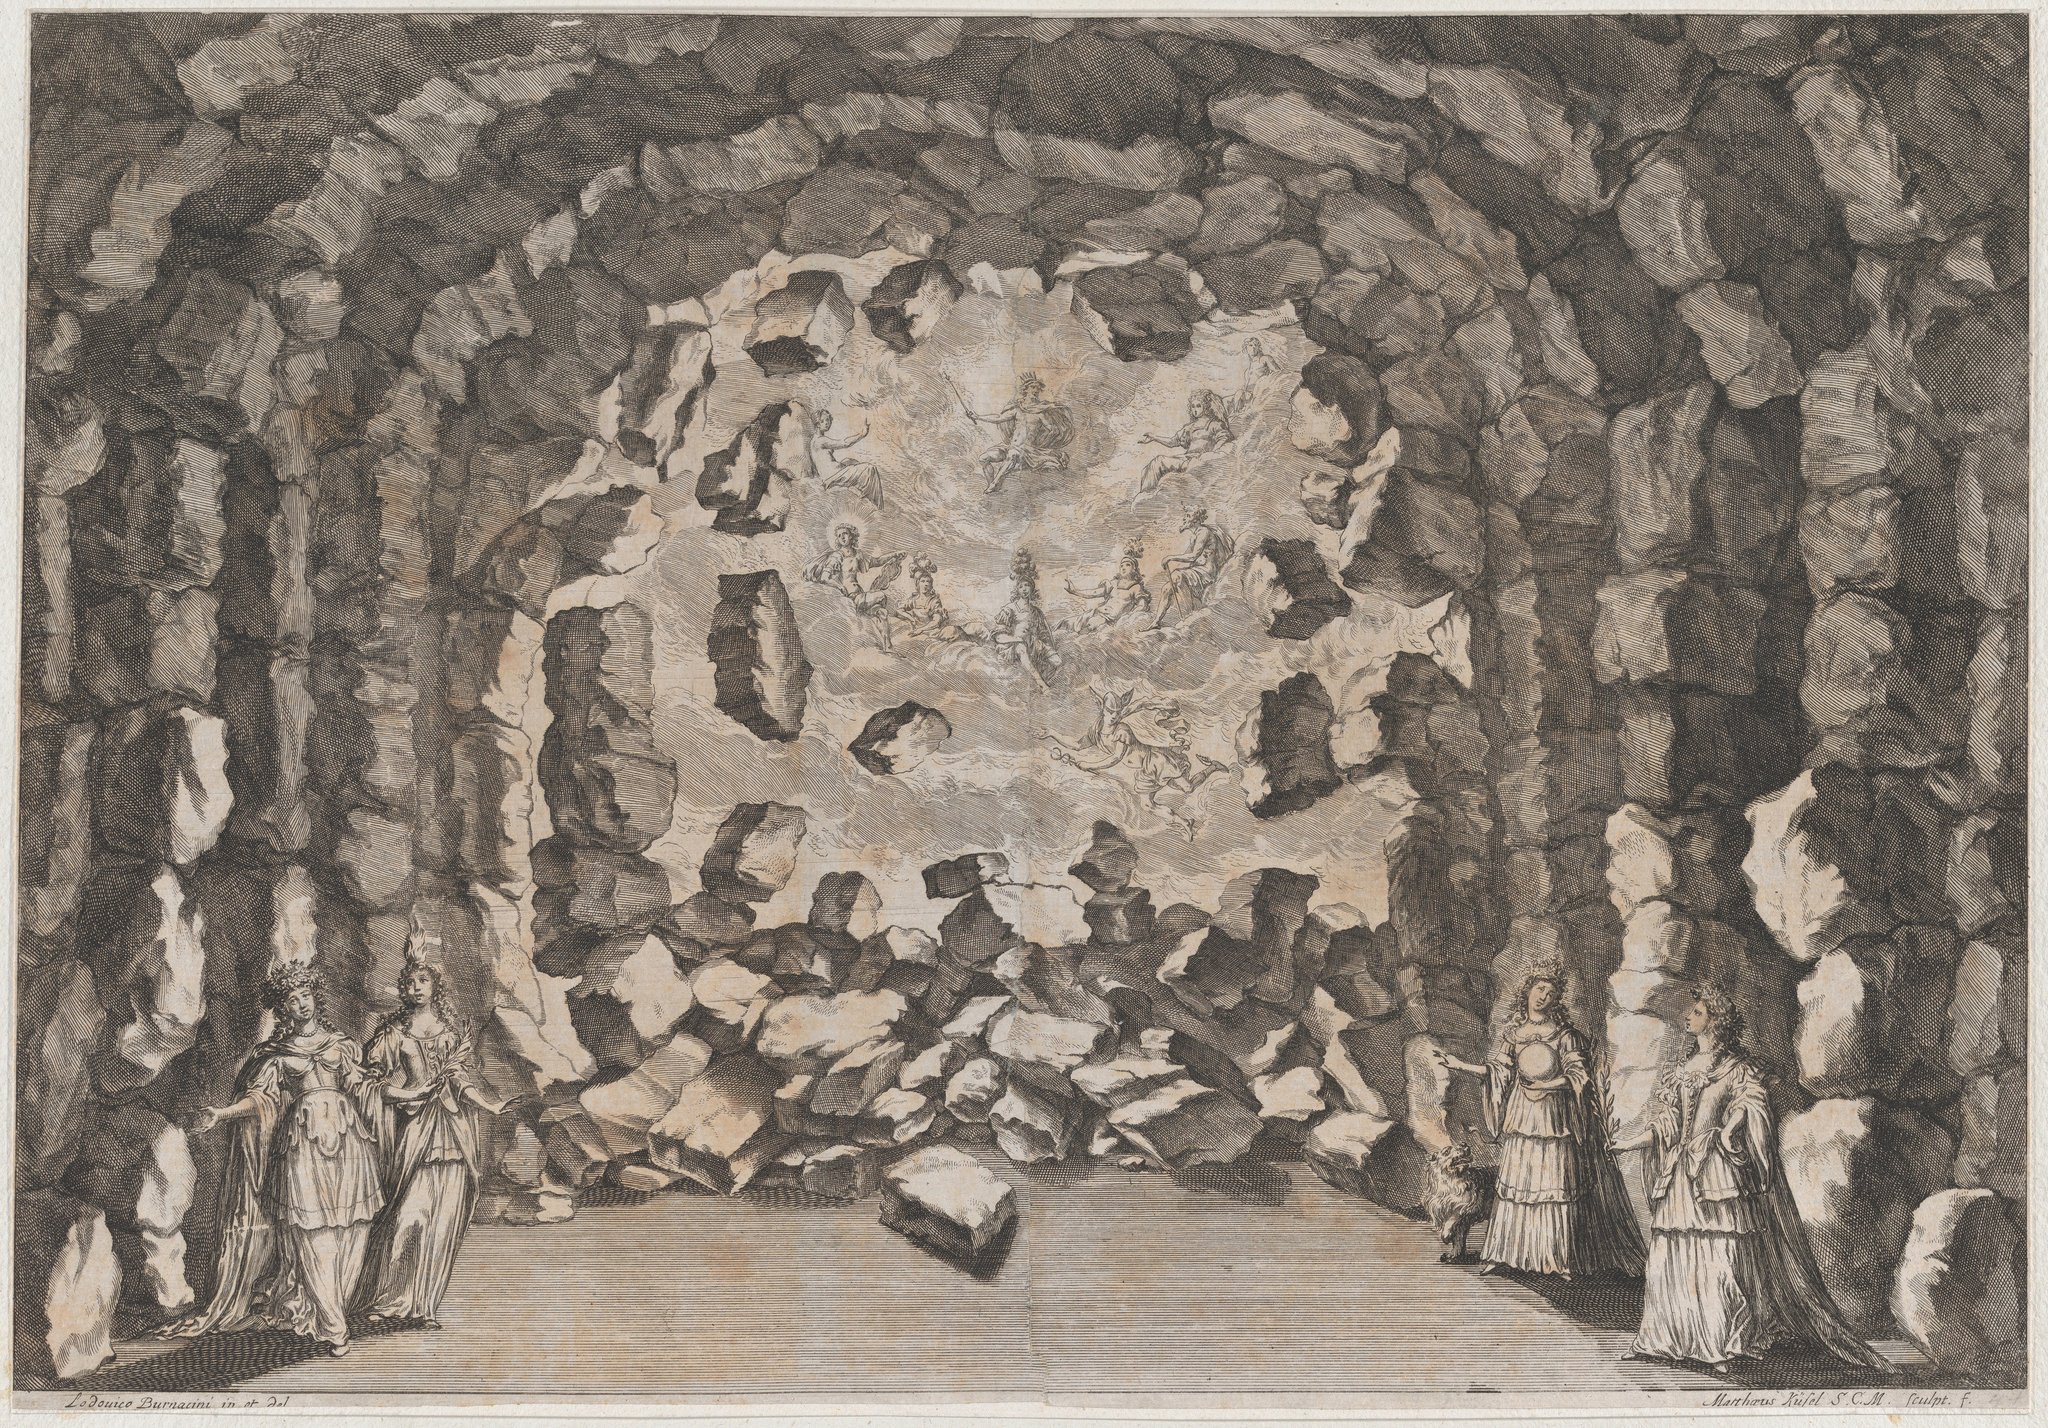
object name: print, fete, ornament architecture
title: A grotto with collapsing rocks, opening to a sky full of the enthroned gods of Olympus, including Jupiter, Apollo, Mars, Venus, and Mercury; set design from 'La Monarchia Latina Trionfante'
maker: mathäus küsel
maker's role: artist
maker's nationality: german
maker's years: 1621-1682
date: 1678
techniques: etching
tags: women,apollo,jupiter,mars,venus,stage design